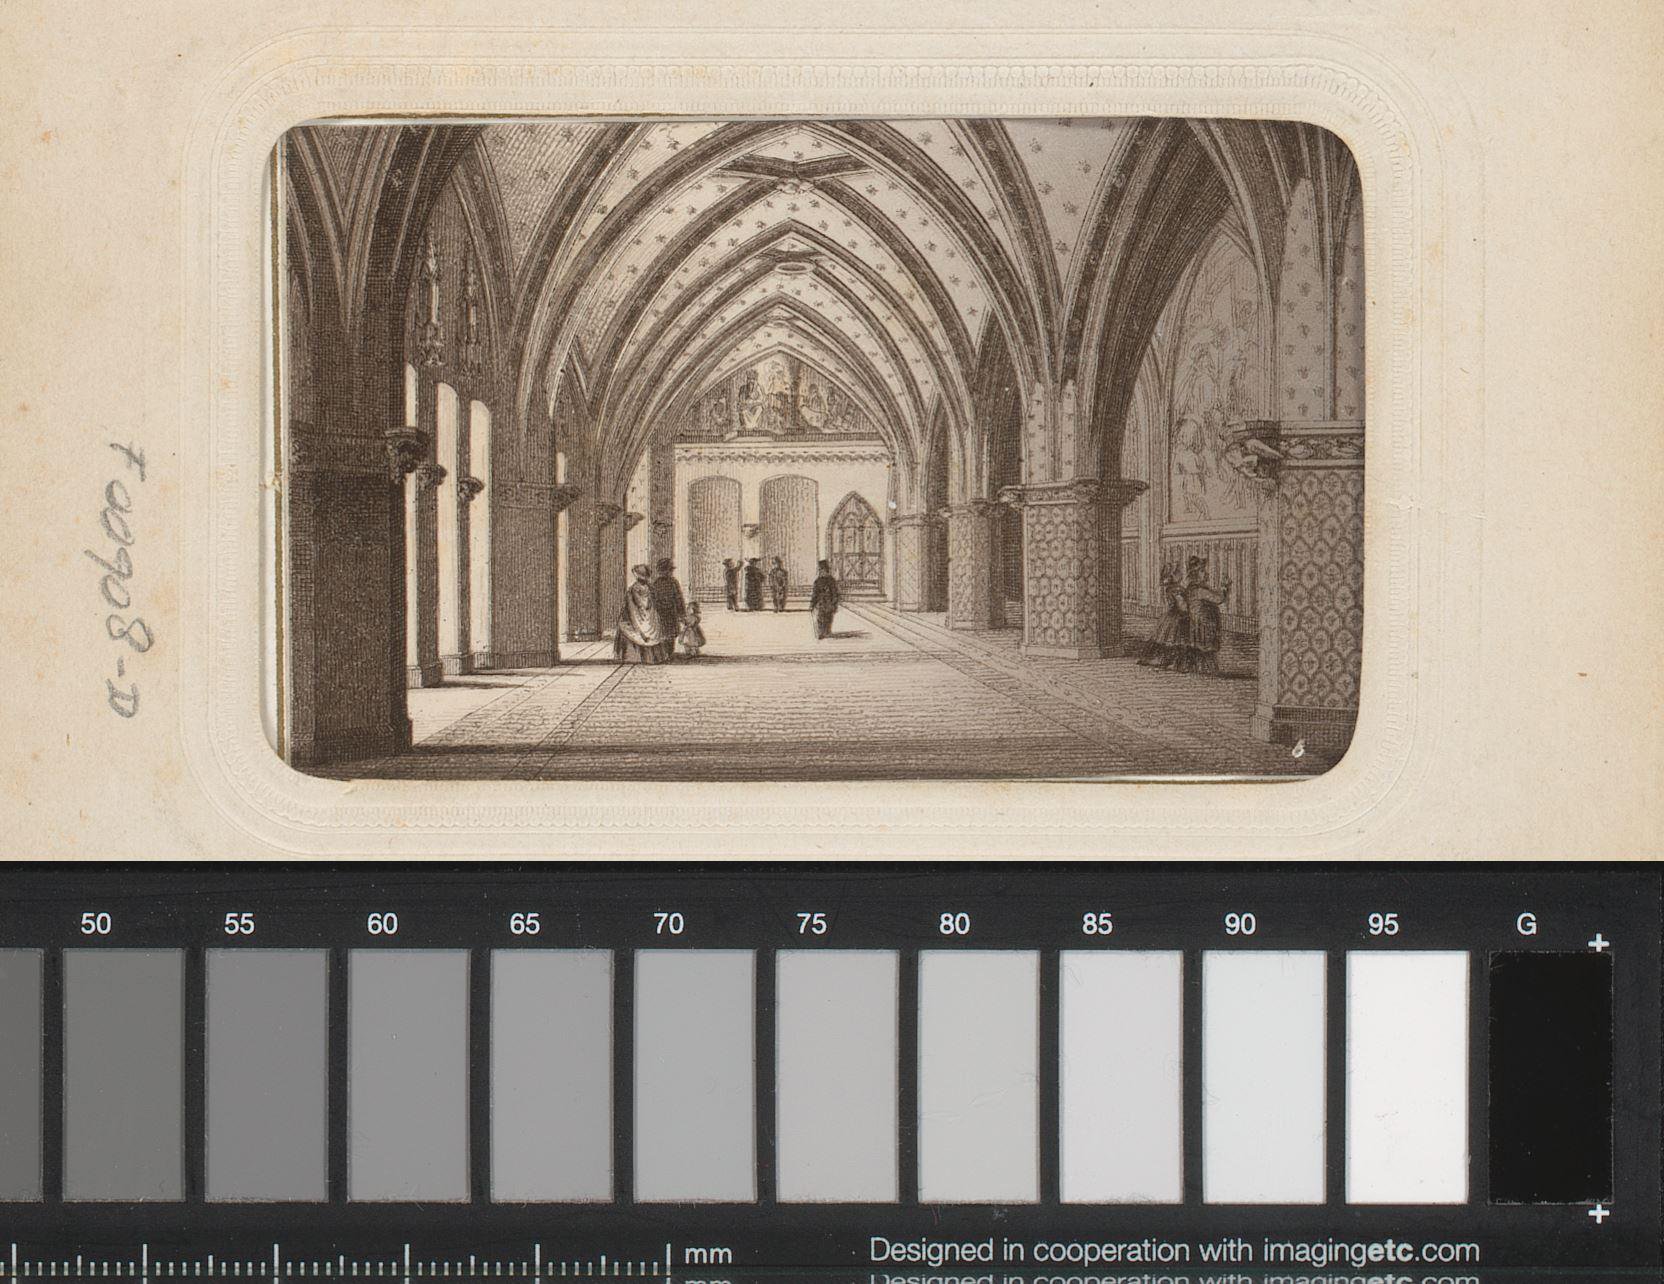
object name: photograph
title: Kaisersaal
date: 1860-1885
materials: cardboard, photographic support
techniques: collodion silver print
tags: column, pillar ~ architecture, interior ~ representation of a building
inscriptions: annotation: ‘Aken/ Keizerszaal’, annotation: ‘Kaisersaal’